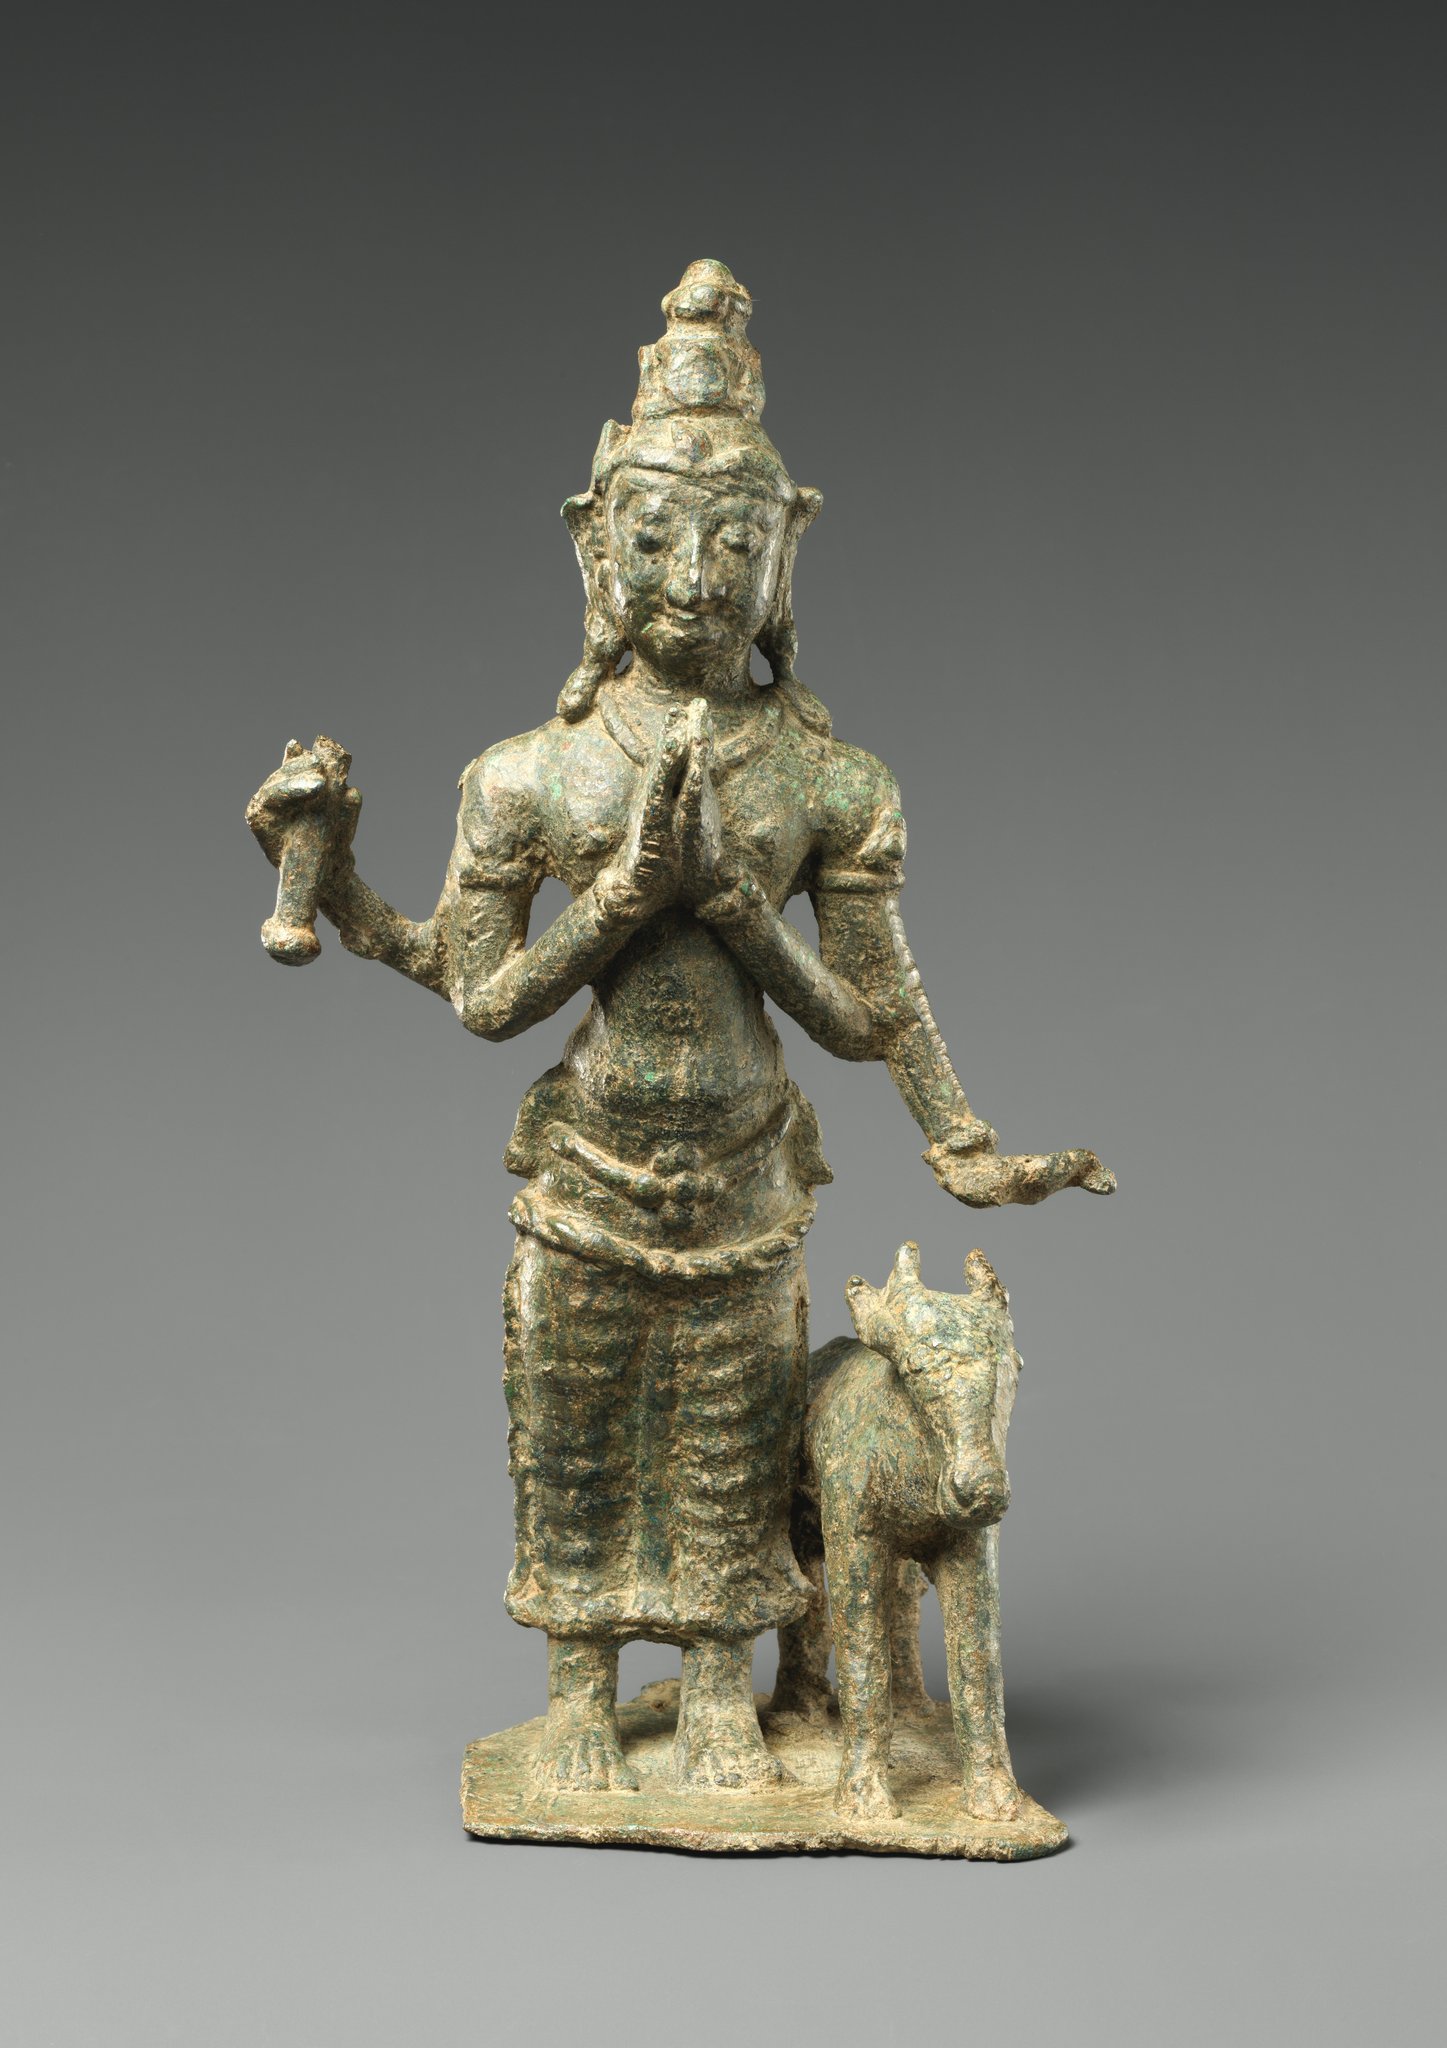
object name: lokapala figure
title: Yama, Lord of Death: Regent of the South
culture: sri lankan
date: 801-900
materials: bronze